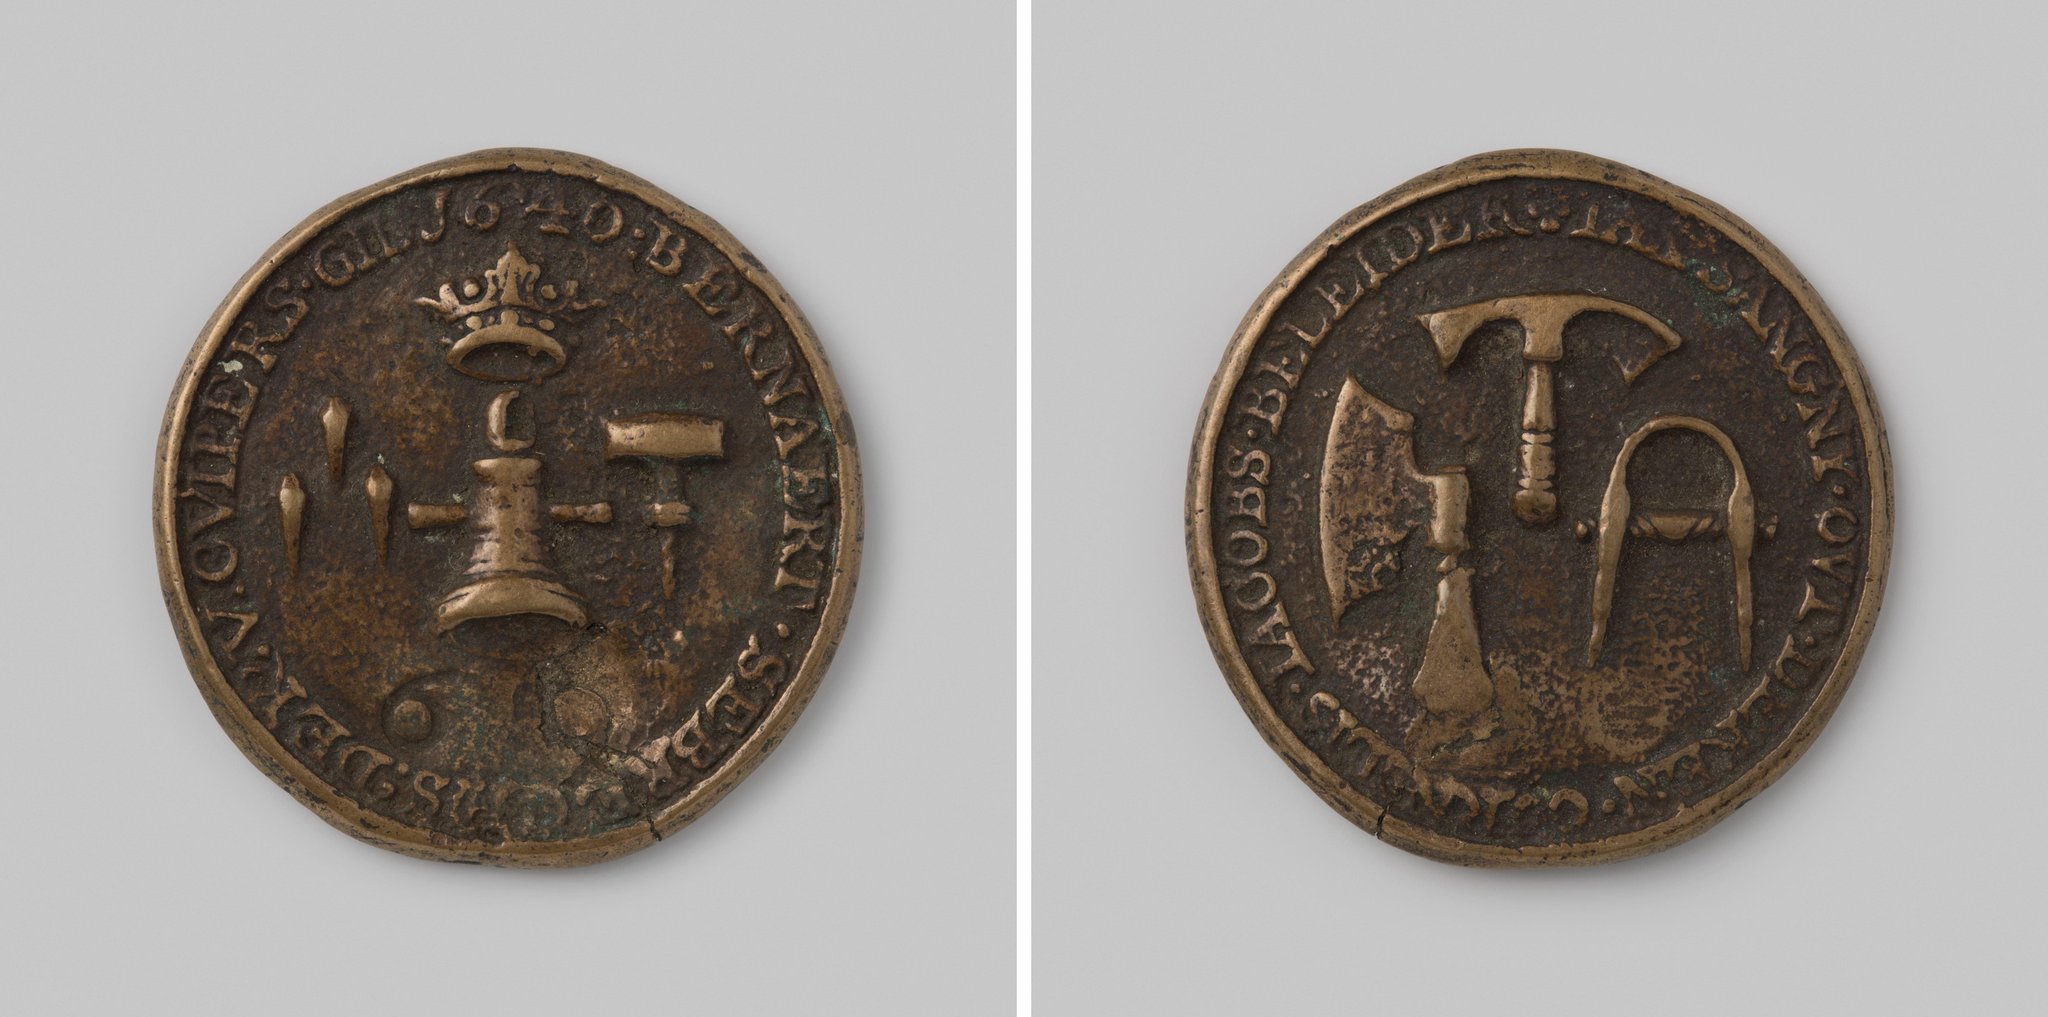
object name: history medal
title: Presentiepenning van het Kuipersgilde te Middelburg, 1640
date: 1640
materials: brass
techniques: casting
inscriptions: circumscription: ‘(roos) IAN SANGNY OVT DEKEN CORNELIS IACOBS BELEIDER’, circumscription: ‘BERNAERT SEBRECHS DEK V CVIPERS GIL 1640’, inscription: ‘66’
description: Gegoten messing penning, op de voorzijde een gekroond aambeeld, drie aandrijvers en een boor, waaronder ingestempeld het getal 66, met omschrift, op de keerzijde bijl, hamer en passer met omschrift